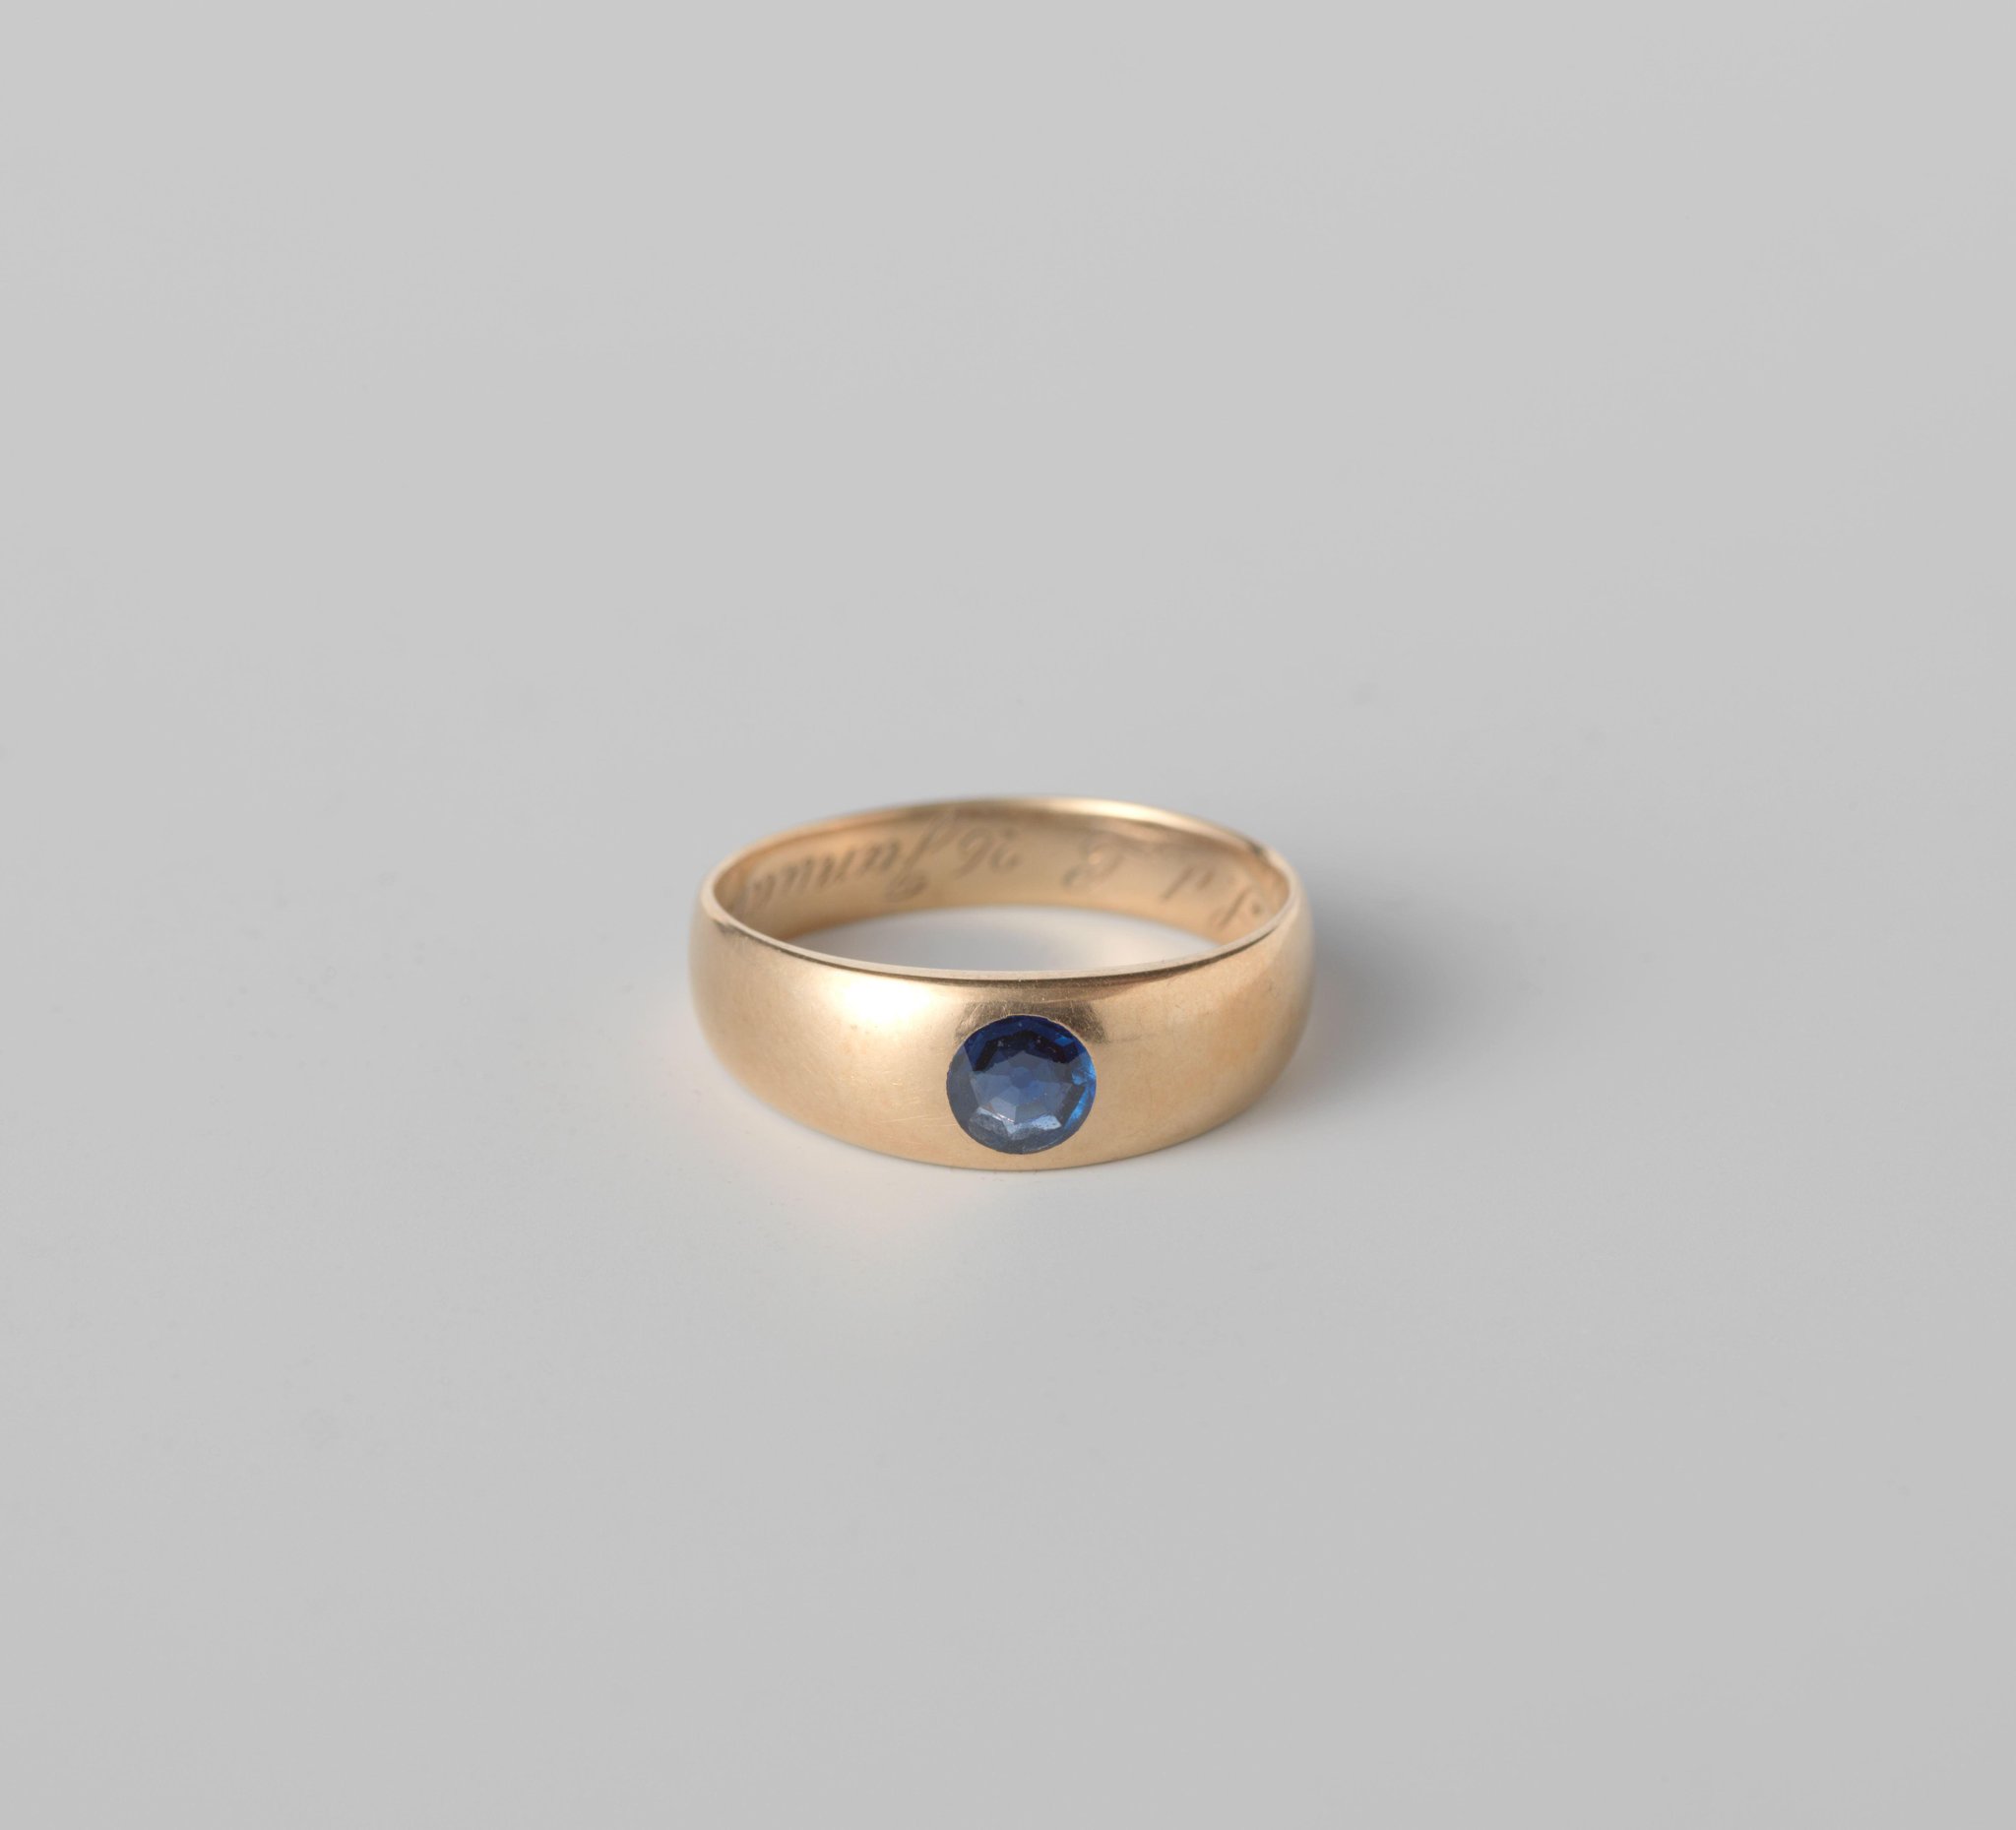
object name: ring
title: Ring van goud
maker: Anonymous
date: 1911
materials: gold, gemstone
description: Gladde band met 1 saffier. Inscriptie: A.J.S. d L 26 Januari 1911.